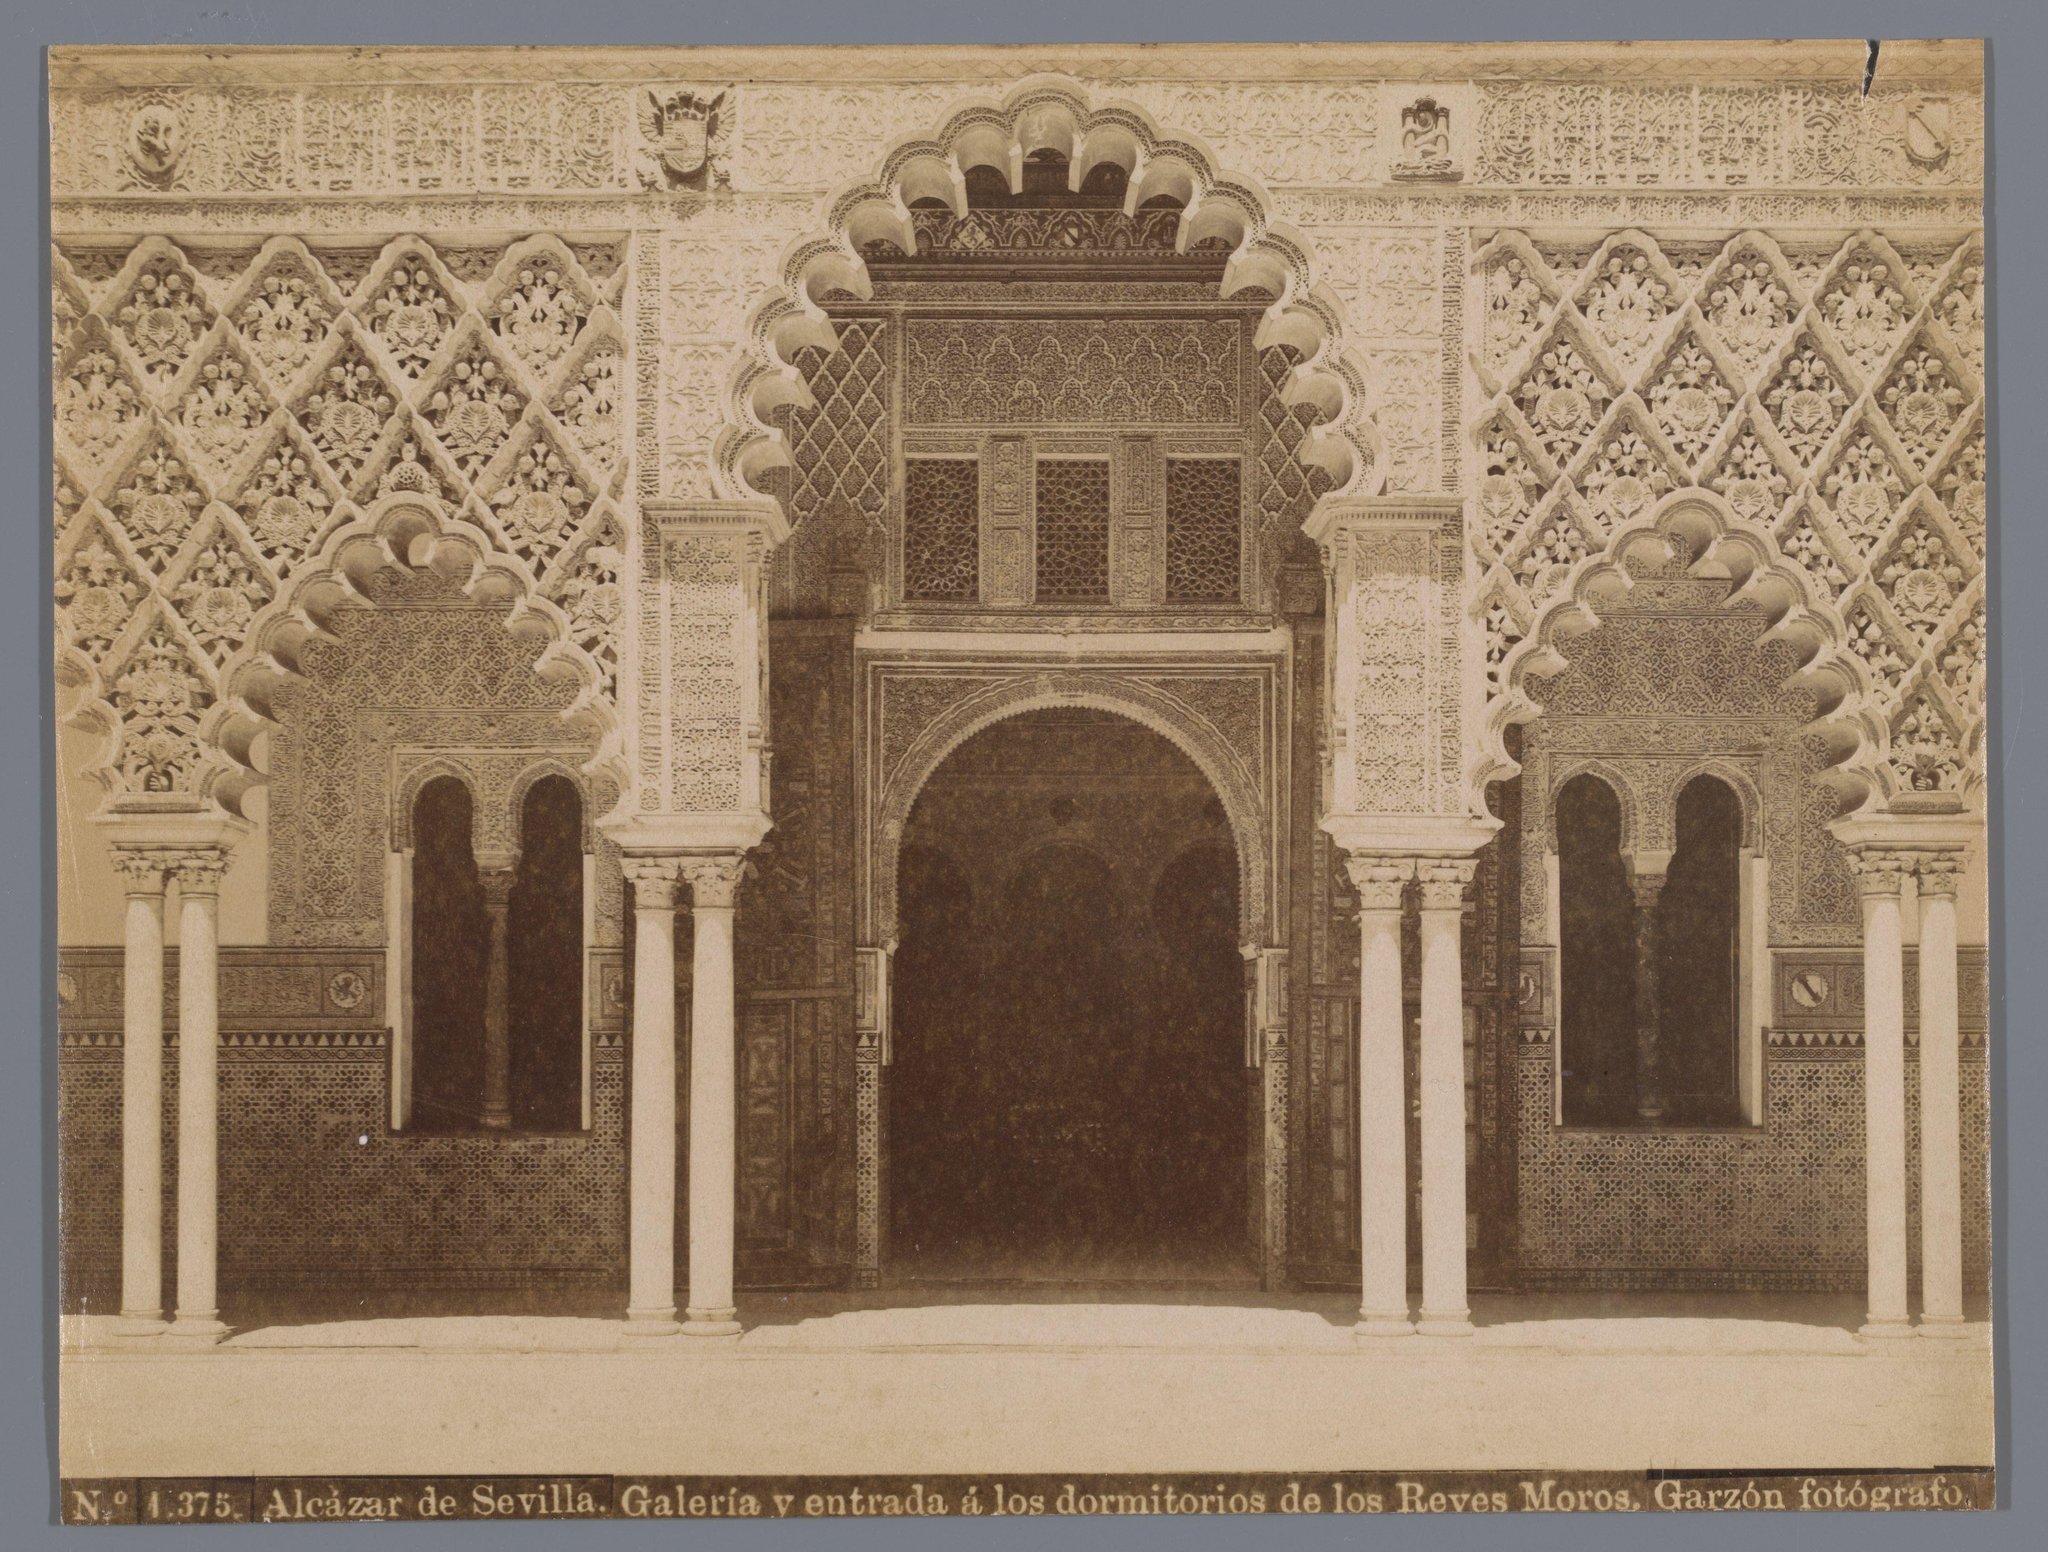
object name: photograph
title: Ingang van de Dormitorio de los Reyes Moros in het Koninklijk Paleis van Sevilla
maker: rafael garzón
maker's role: publisher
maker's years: 1863-1923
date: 1880-1900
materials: paper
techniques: albumen print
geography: sevilla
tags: palace - aa - civic architecture: inside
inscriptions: number: ‘No 1.375.’